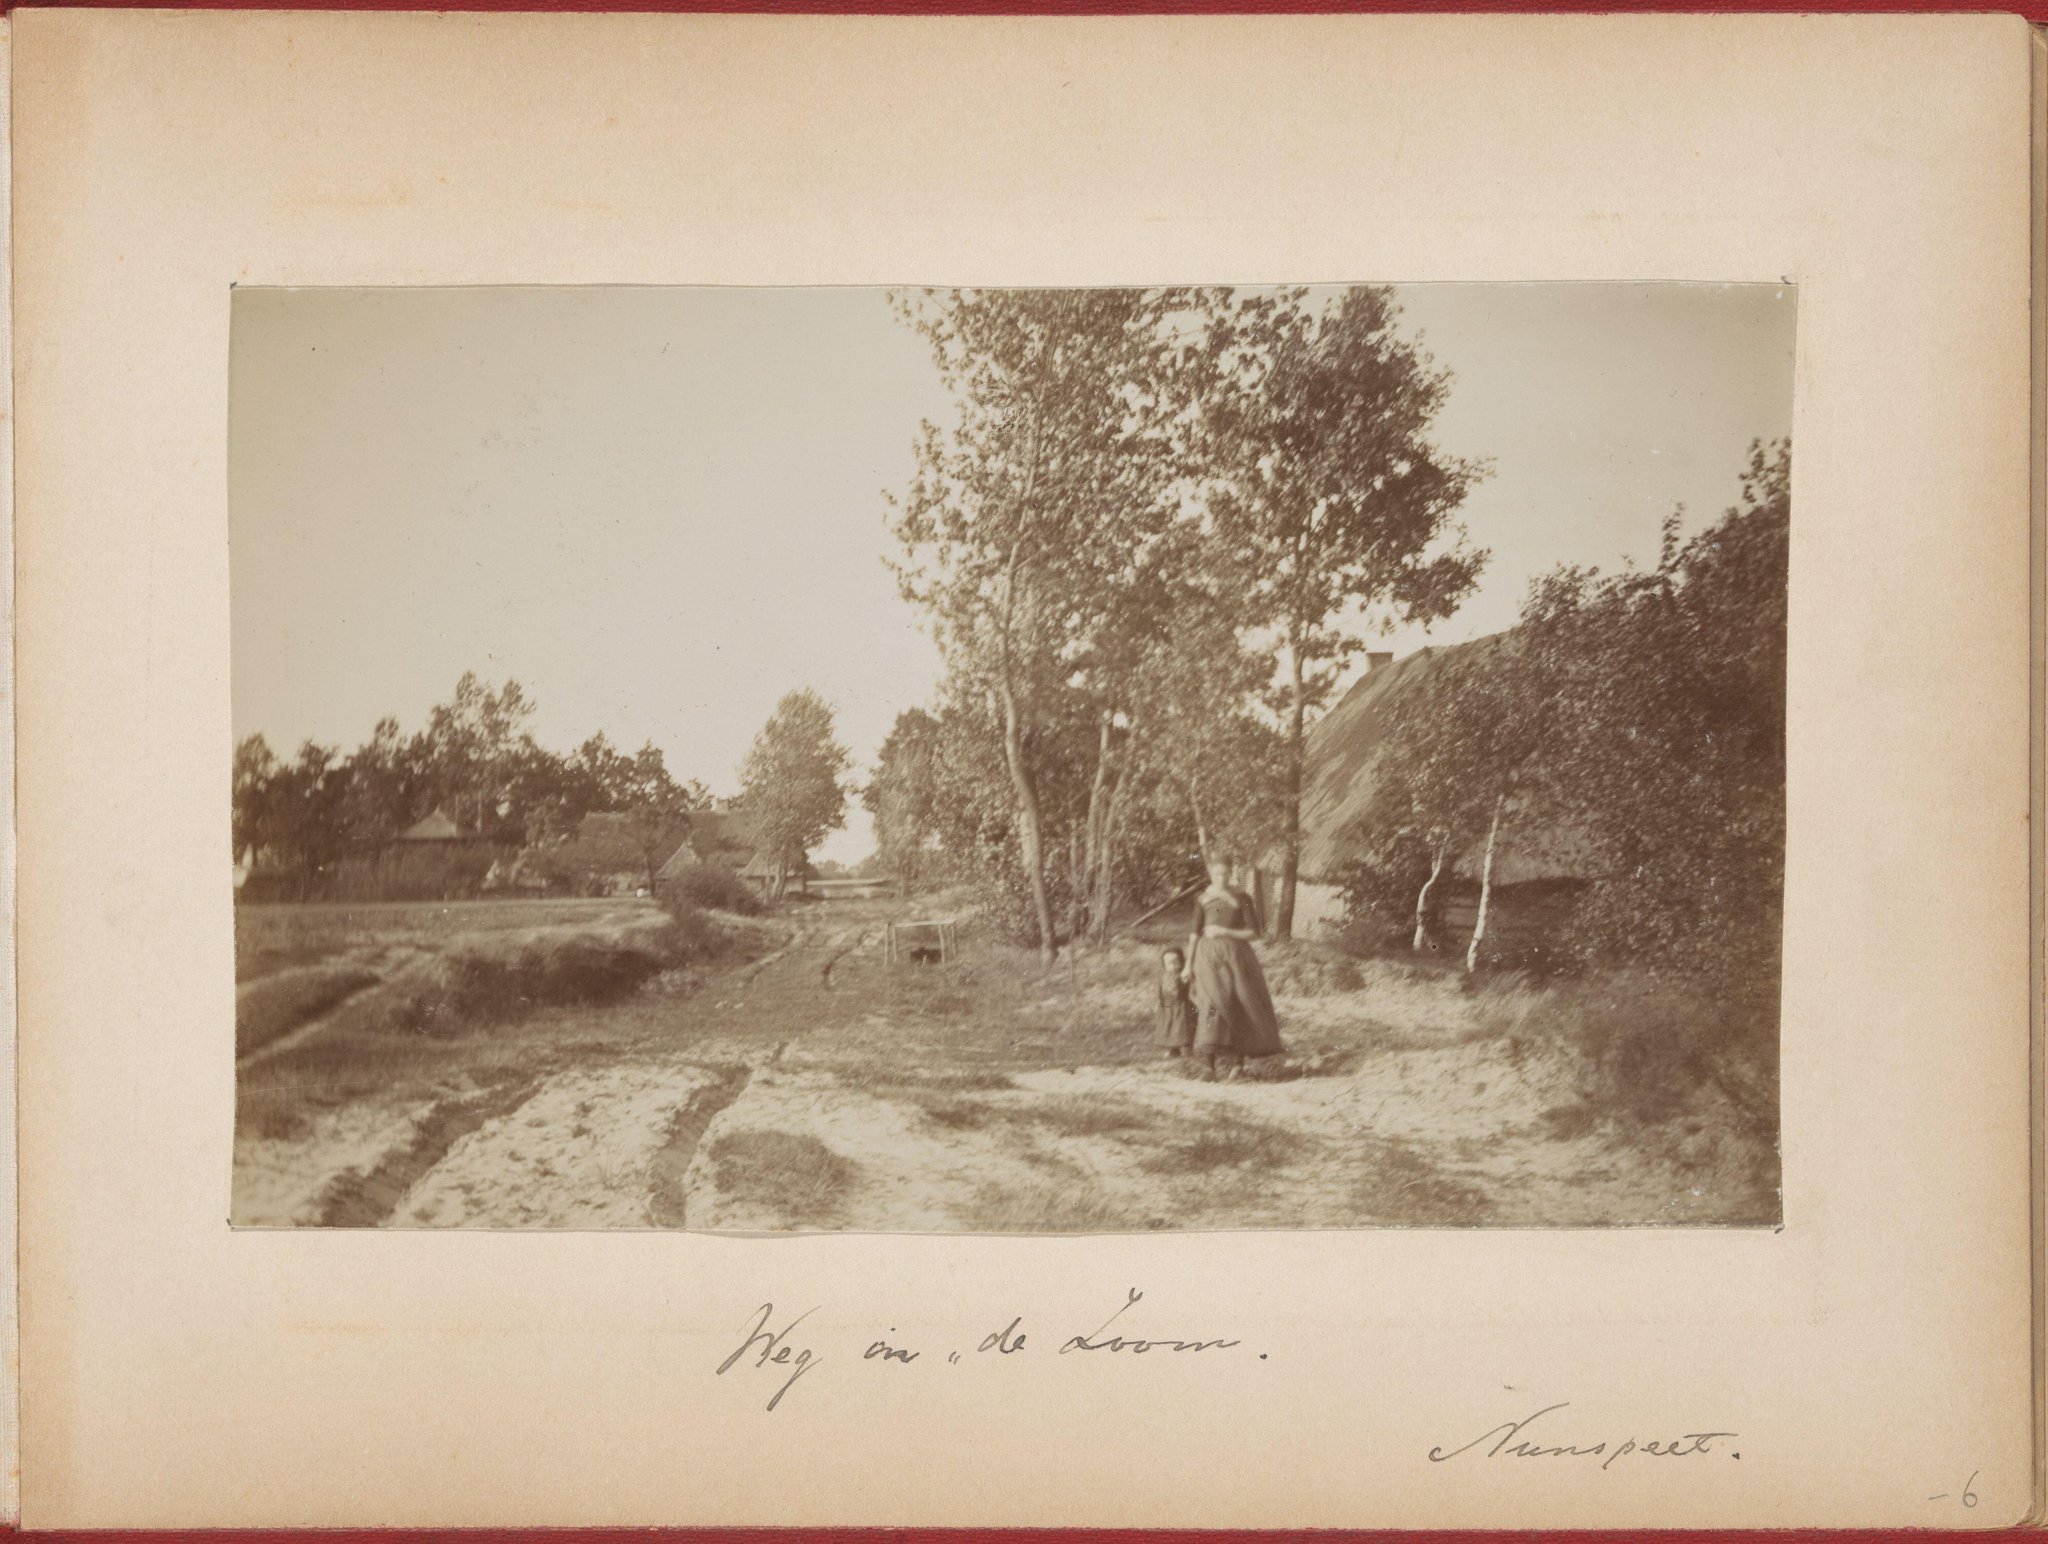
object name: photograph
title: Boerin en kind op weggetje in "de Zoom" in Nunspeet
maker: gerard aalbersberg (us)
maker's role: amateurfotograaf, arts, chirurg, gynaecoloog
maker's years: 1870-1934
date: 1897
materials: paper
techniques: collodion silver print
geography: nunspeet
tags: nunspeet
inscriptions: title: ‘Weg in "de Zoom" Nunspeet’